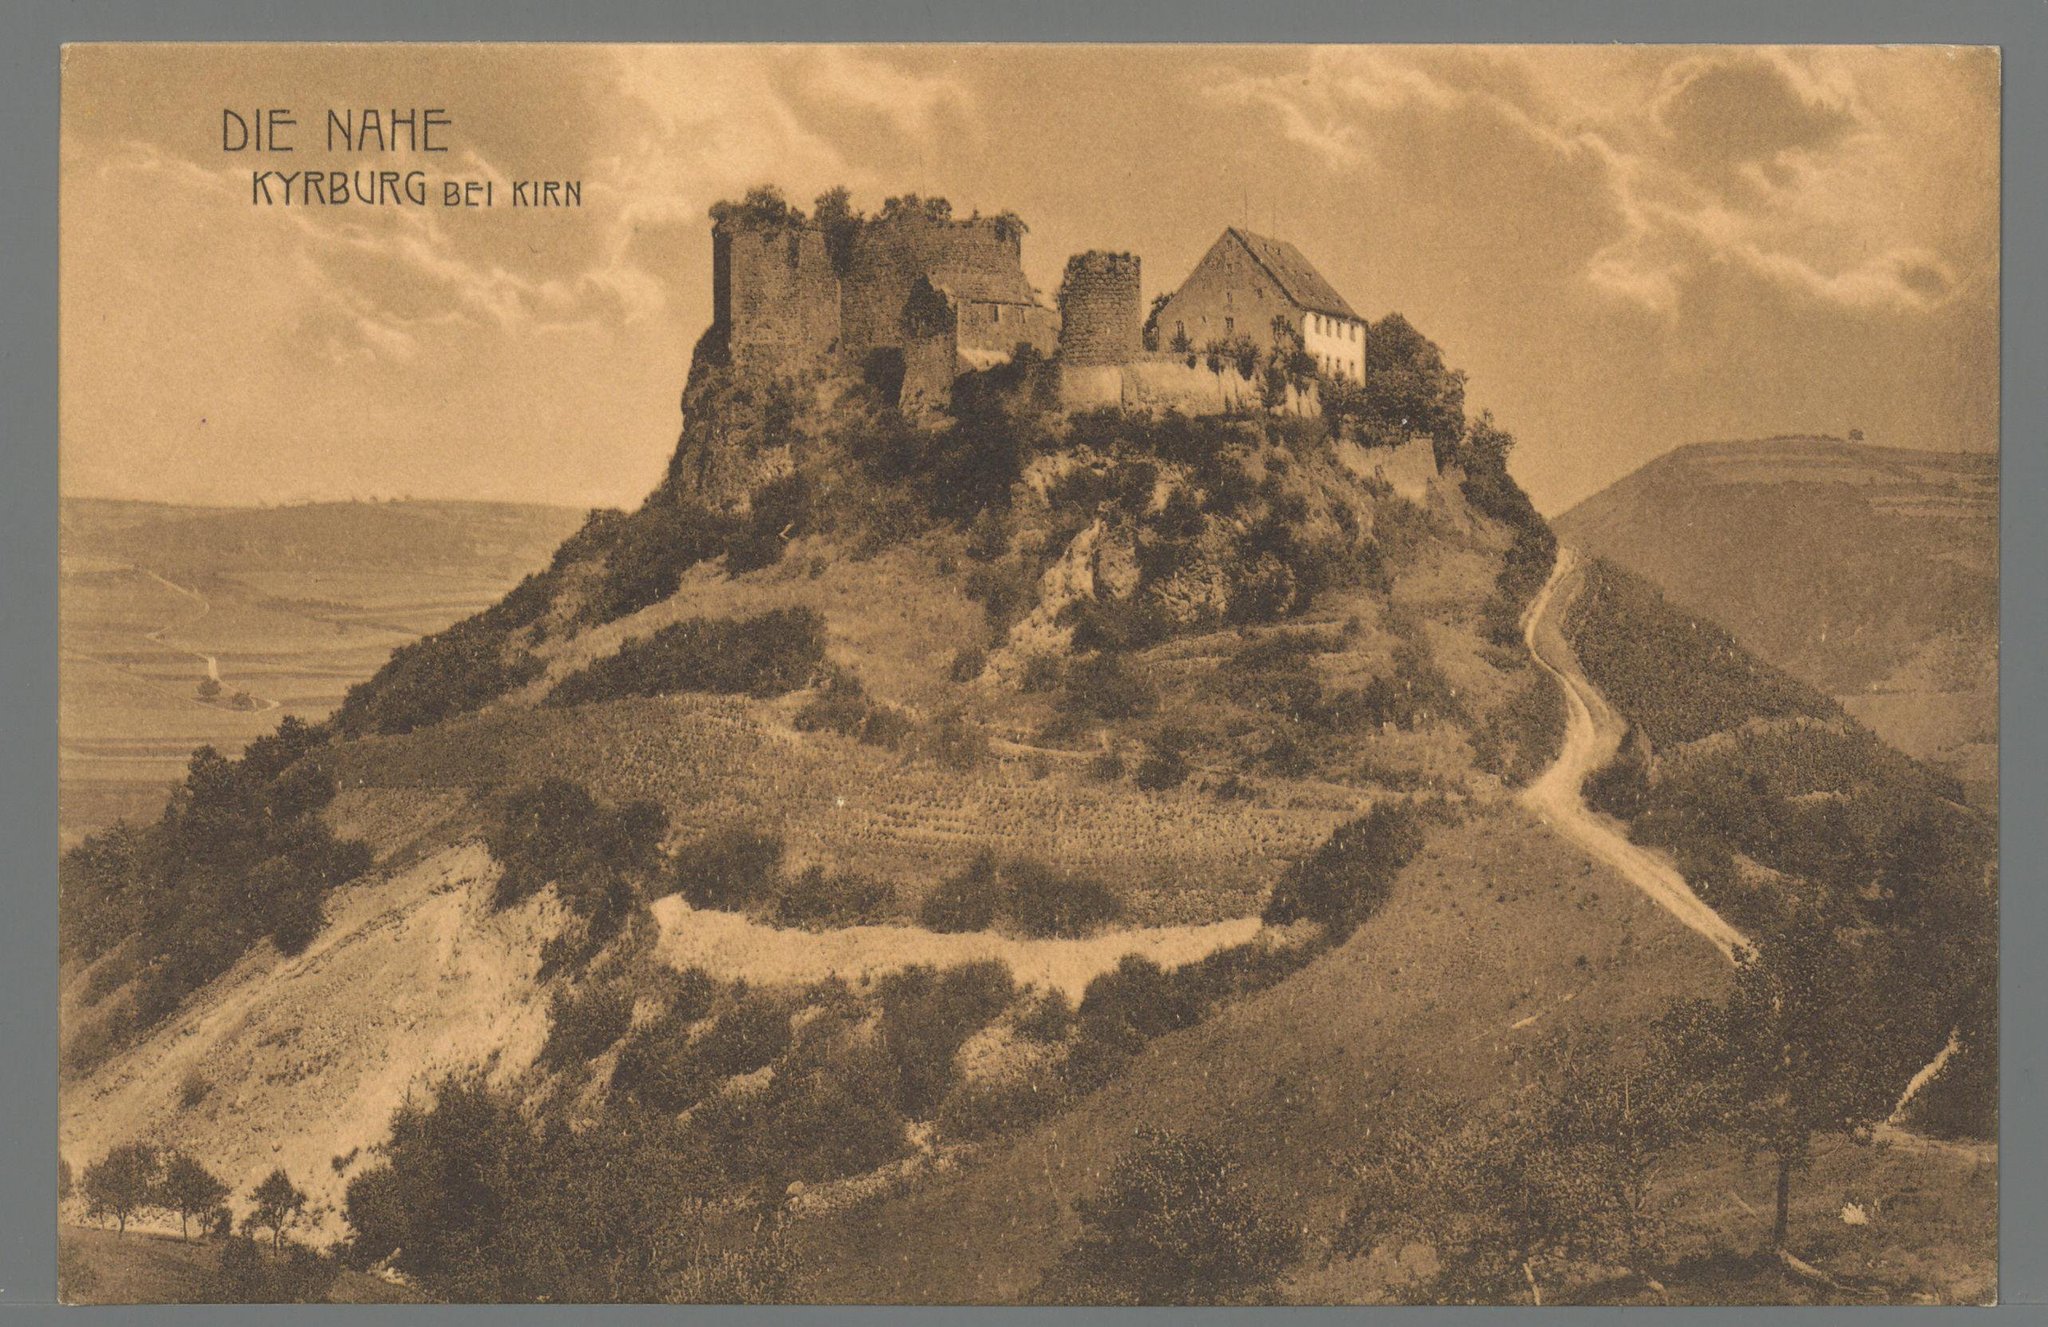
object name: photomechanical print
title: Die Nahe. Kyrburg bei Kirn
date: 1907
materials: cardboard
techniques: photograph, writing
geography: mainz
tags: castle, mountains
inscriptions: date